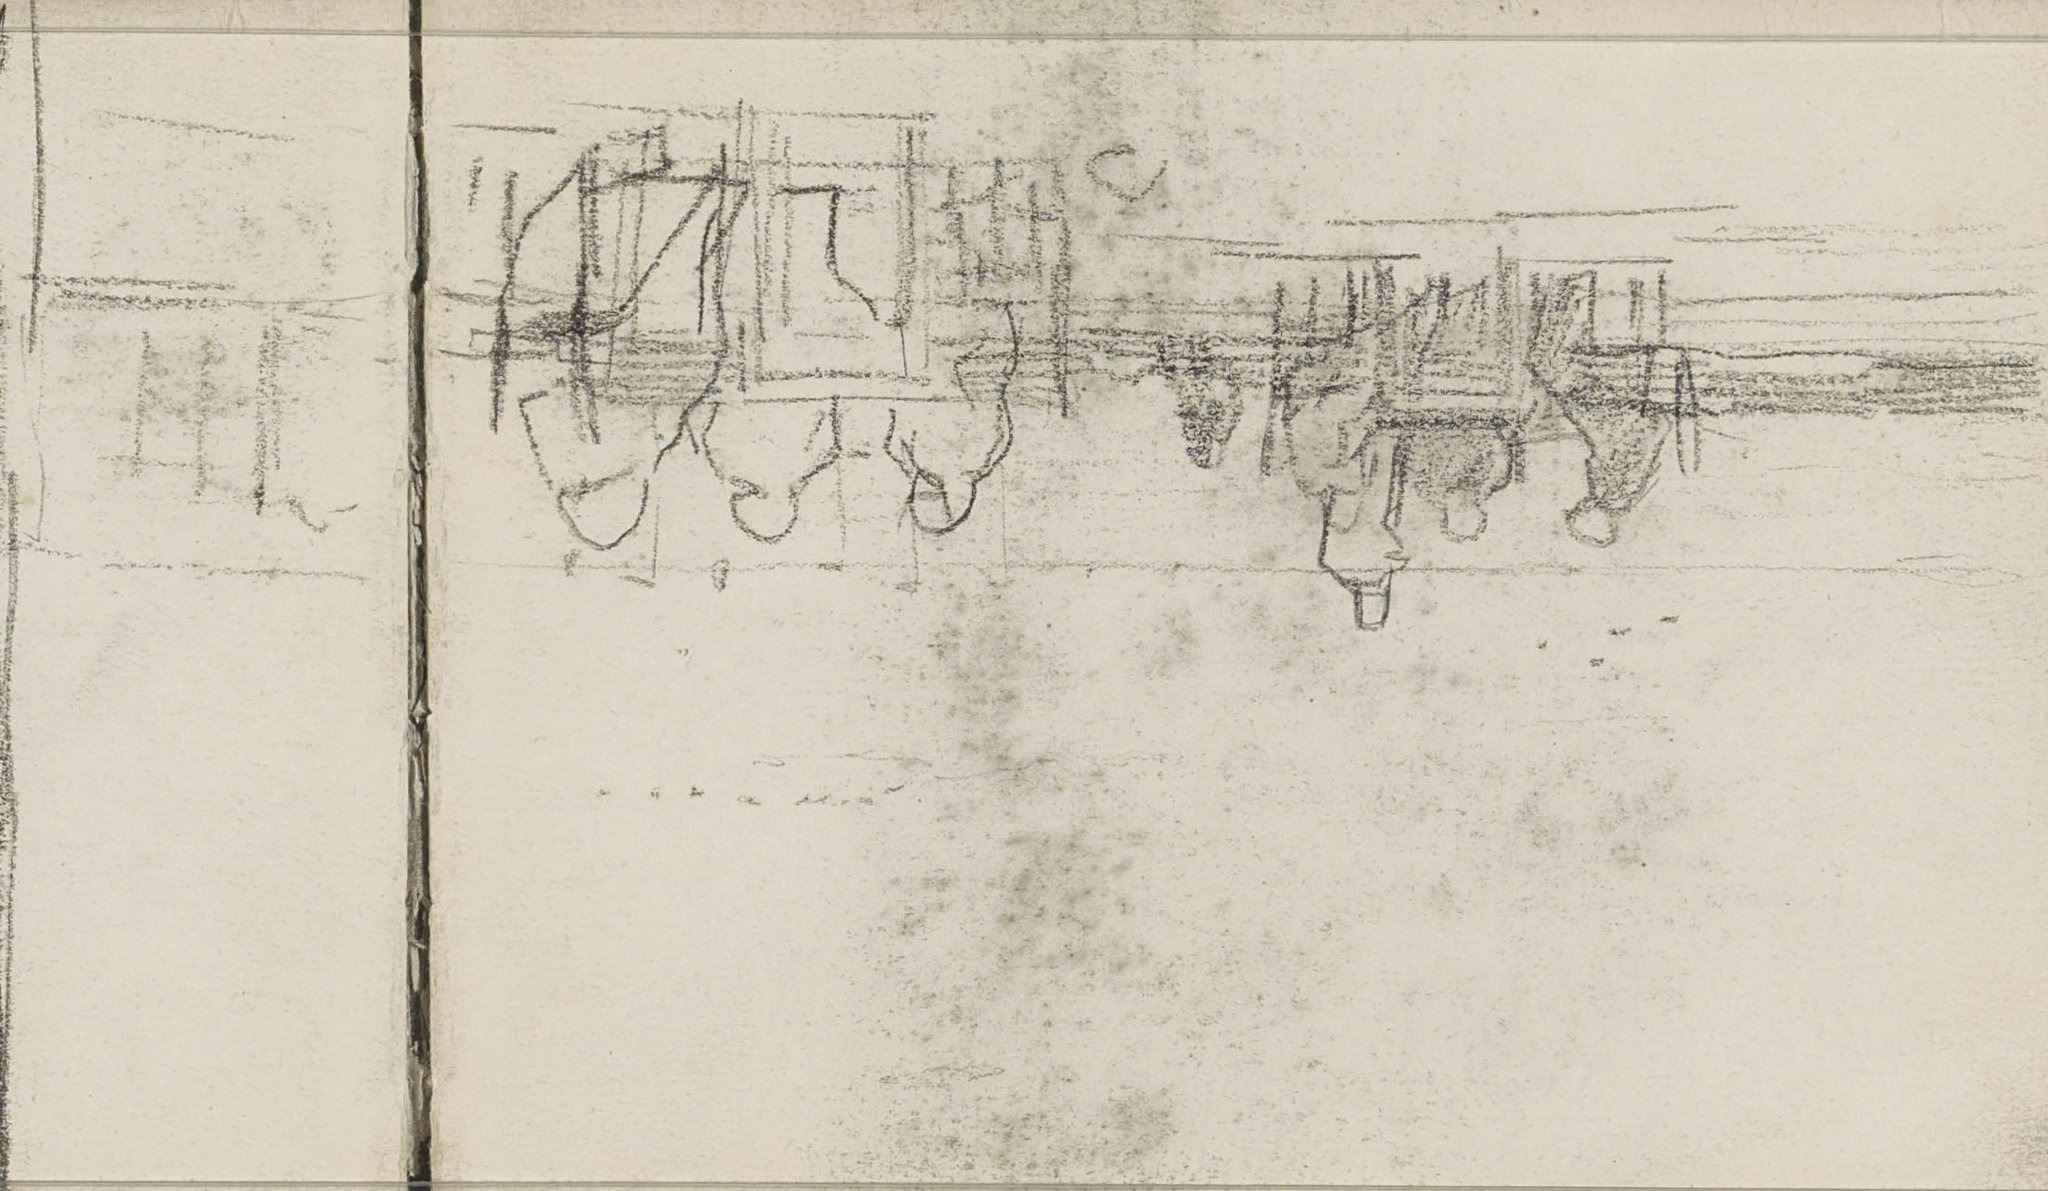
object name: sketchbook leaf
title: Mensen op een terras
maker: anton mauve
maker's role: draughtsman, painter, print maker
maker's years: 1838-1888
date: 1848-1888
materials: chalk, paper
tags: inn, coffee-house, public house, etc.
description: Mogelijk een terras op een boulevard. Blad 19 recto uit een schetsboek met 33 bladen.